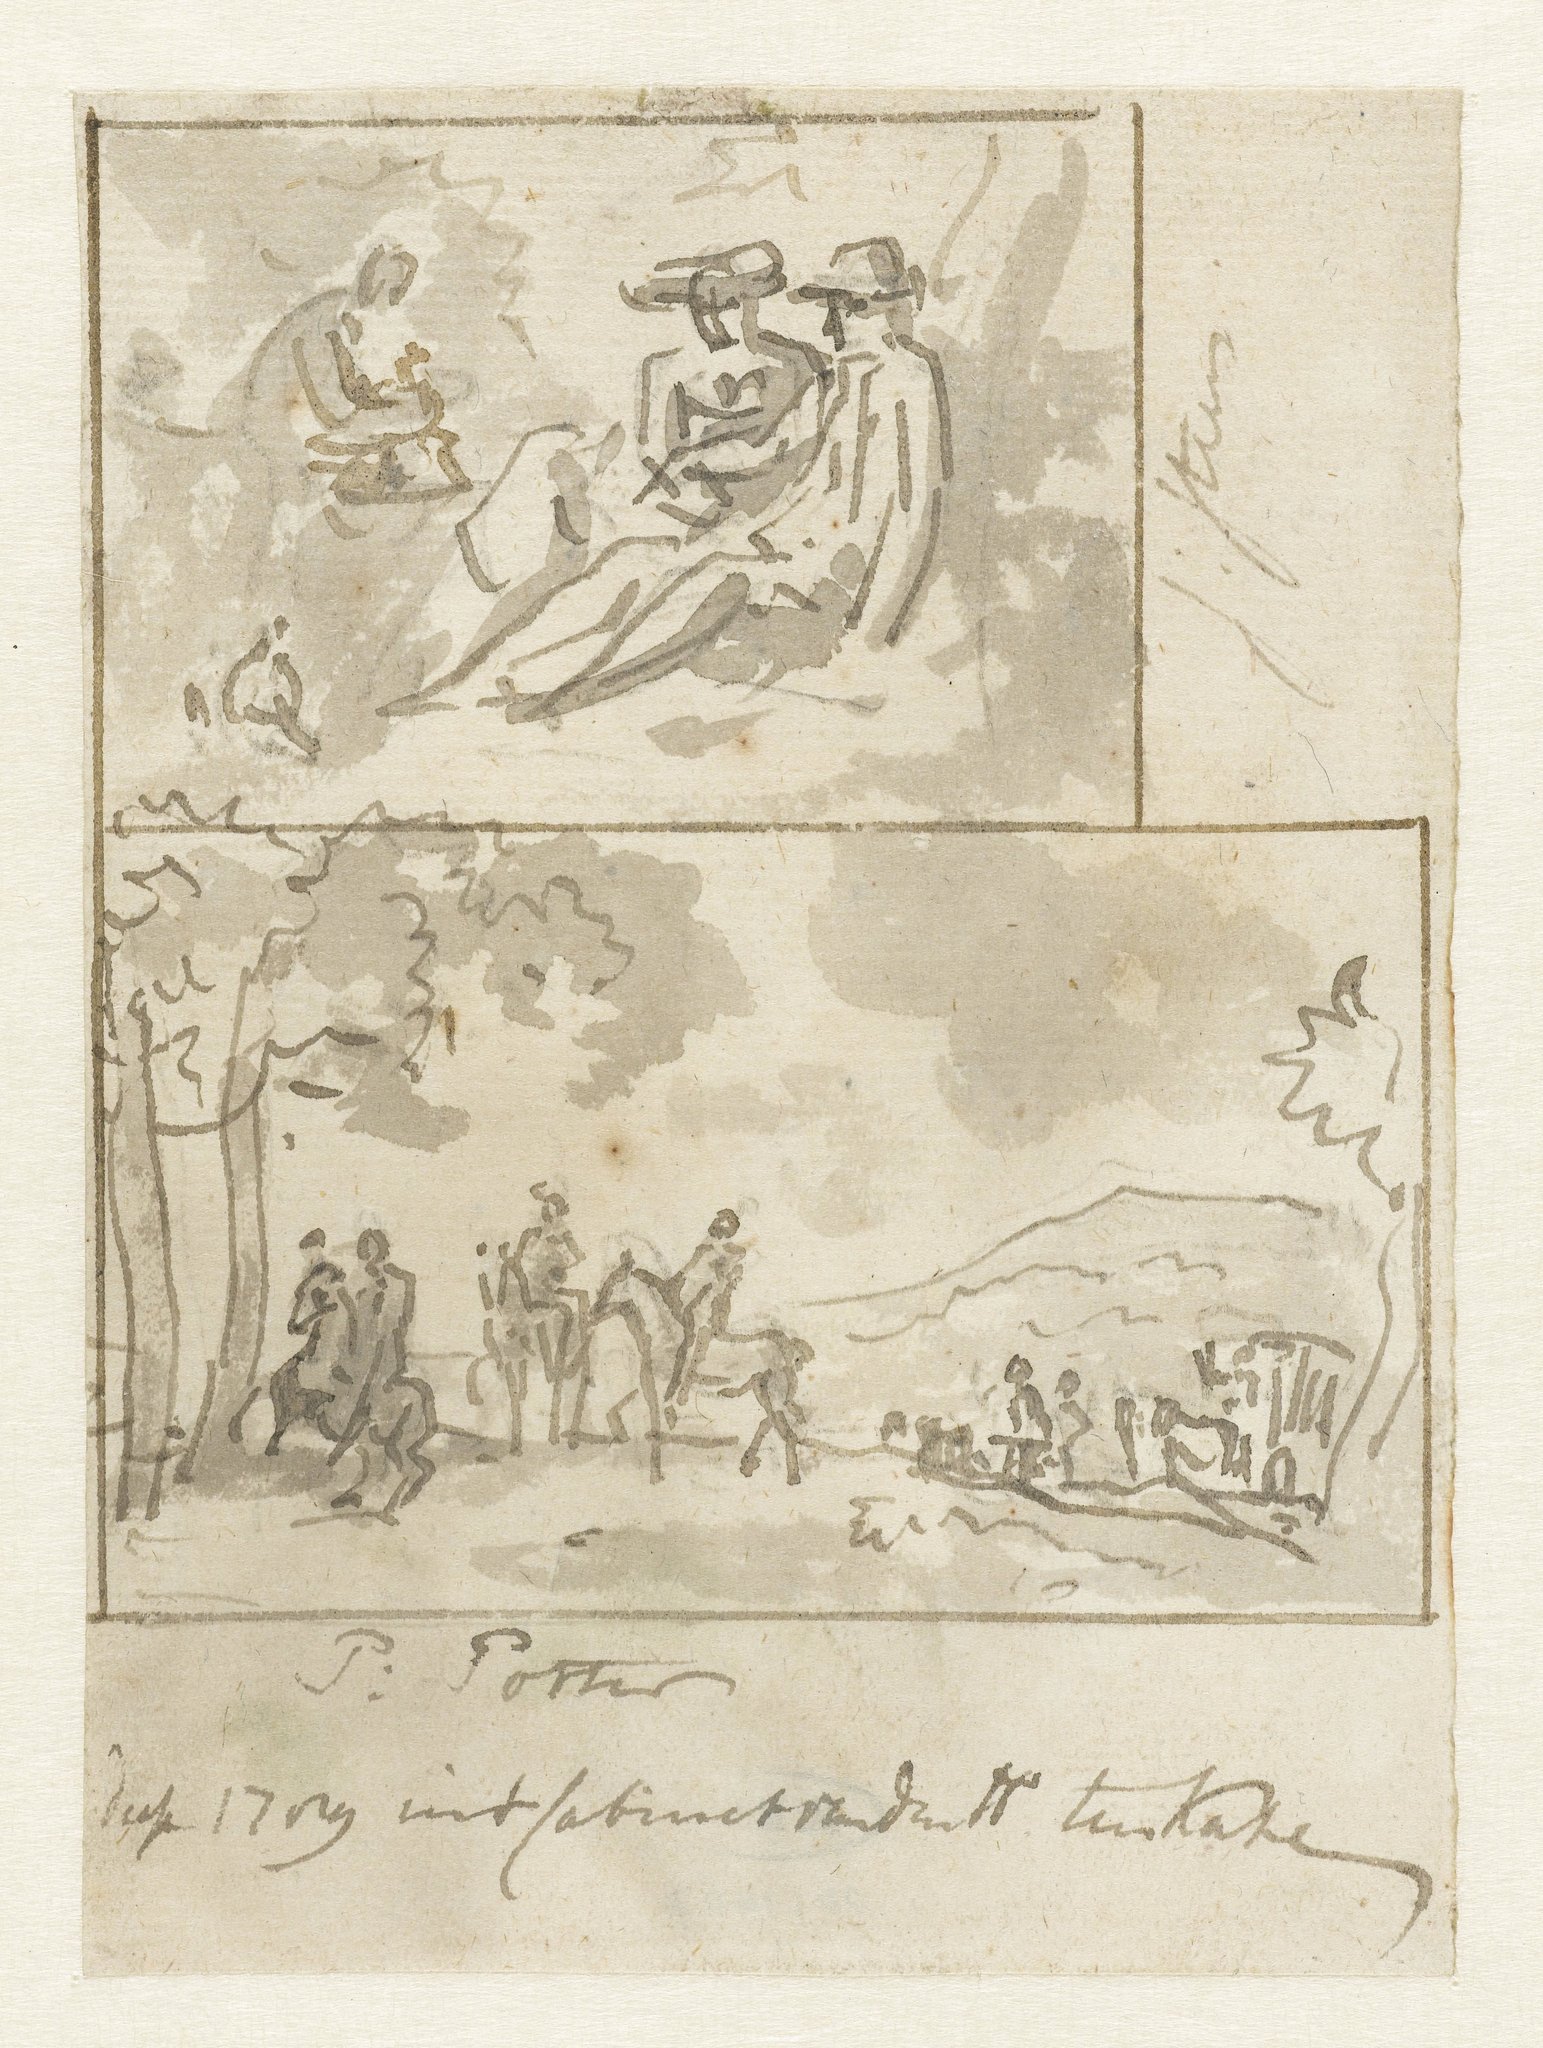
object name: drawing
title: Schetsen van twee zittende figuren en een landschap met mensen te paard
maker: jurriaan andriessen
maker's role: draughtsman, painter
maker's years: 1742-1819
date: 1789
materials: graphite, ink, paper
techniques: brush, pen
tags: picture, painting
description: In het kader bovenaan twee zittende figuren en in het kader onderaan en landschap met mensen te paard.